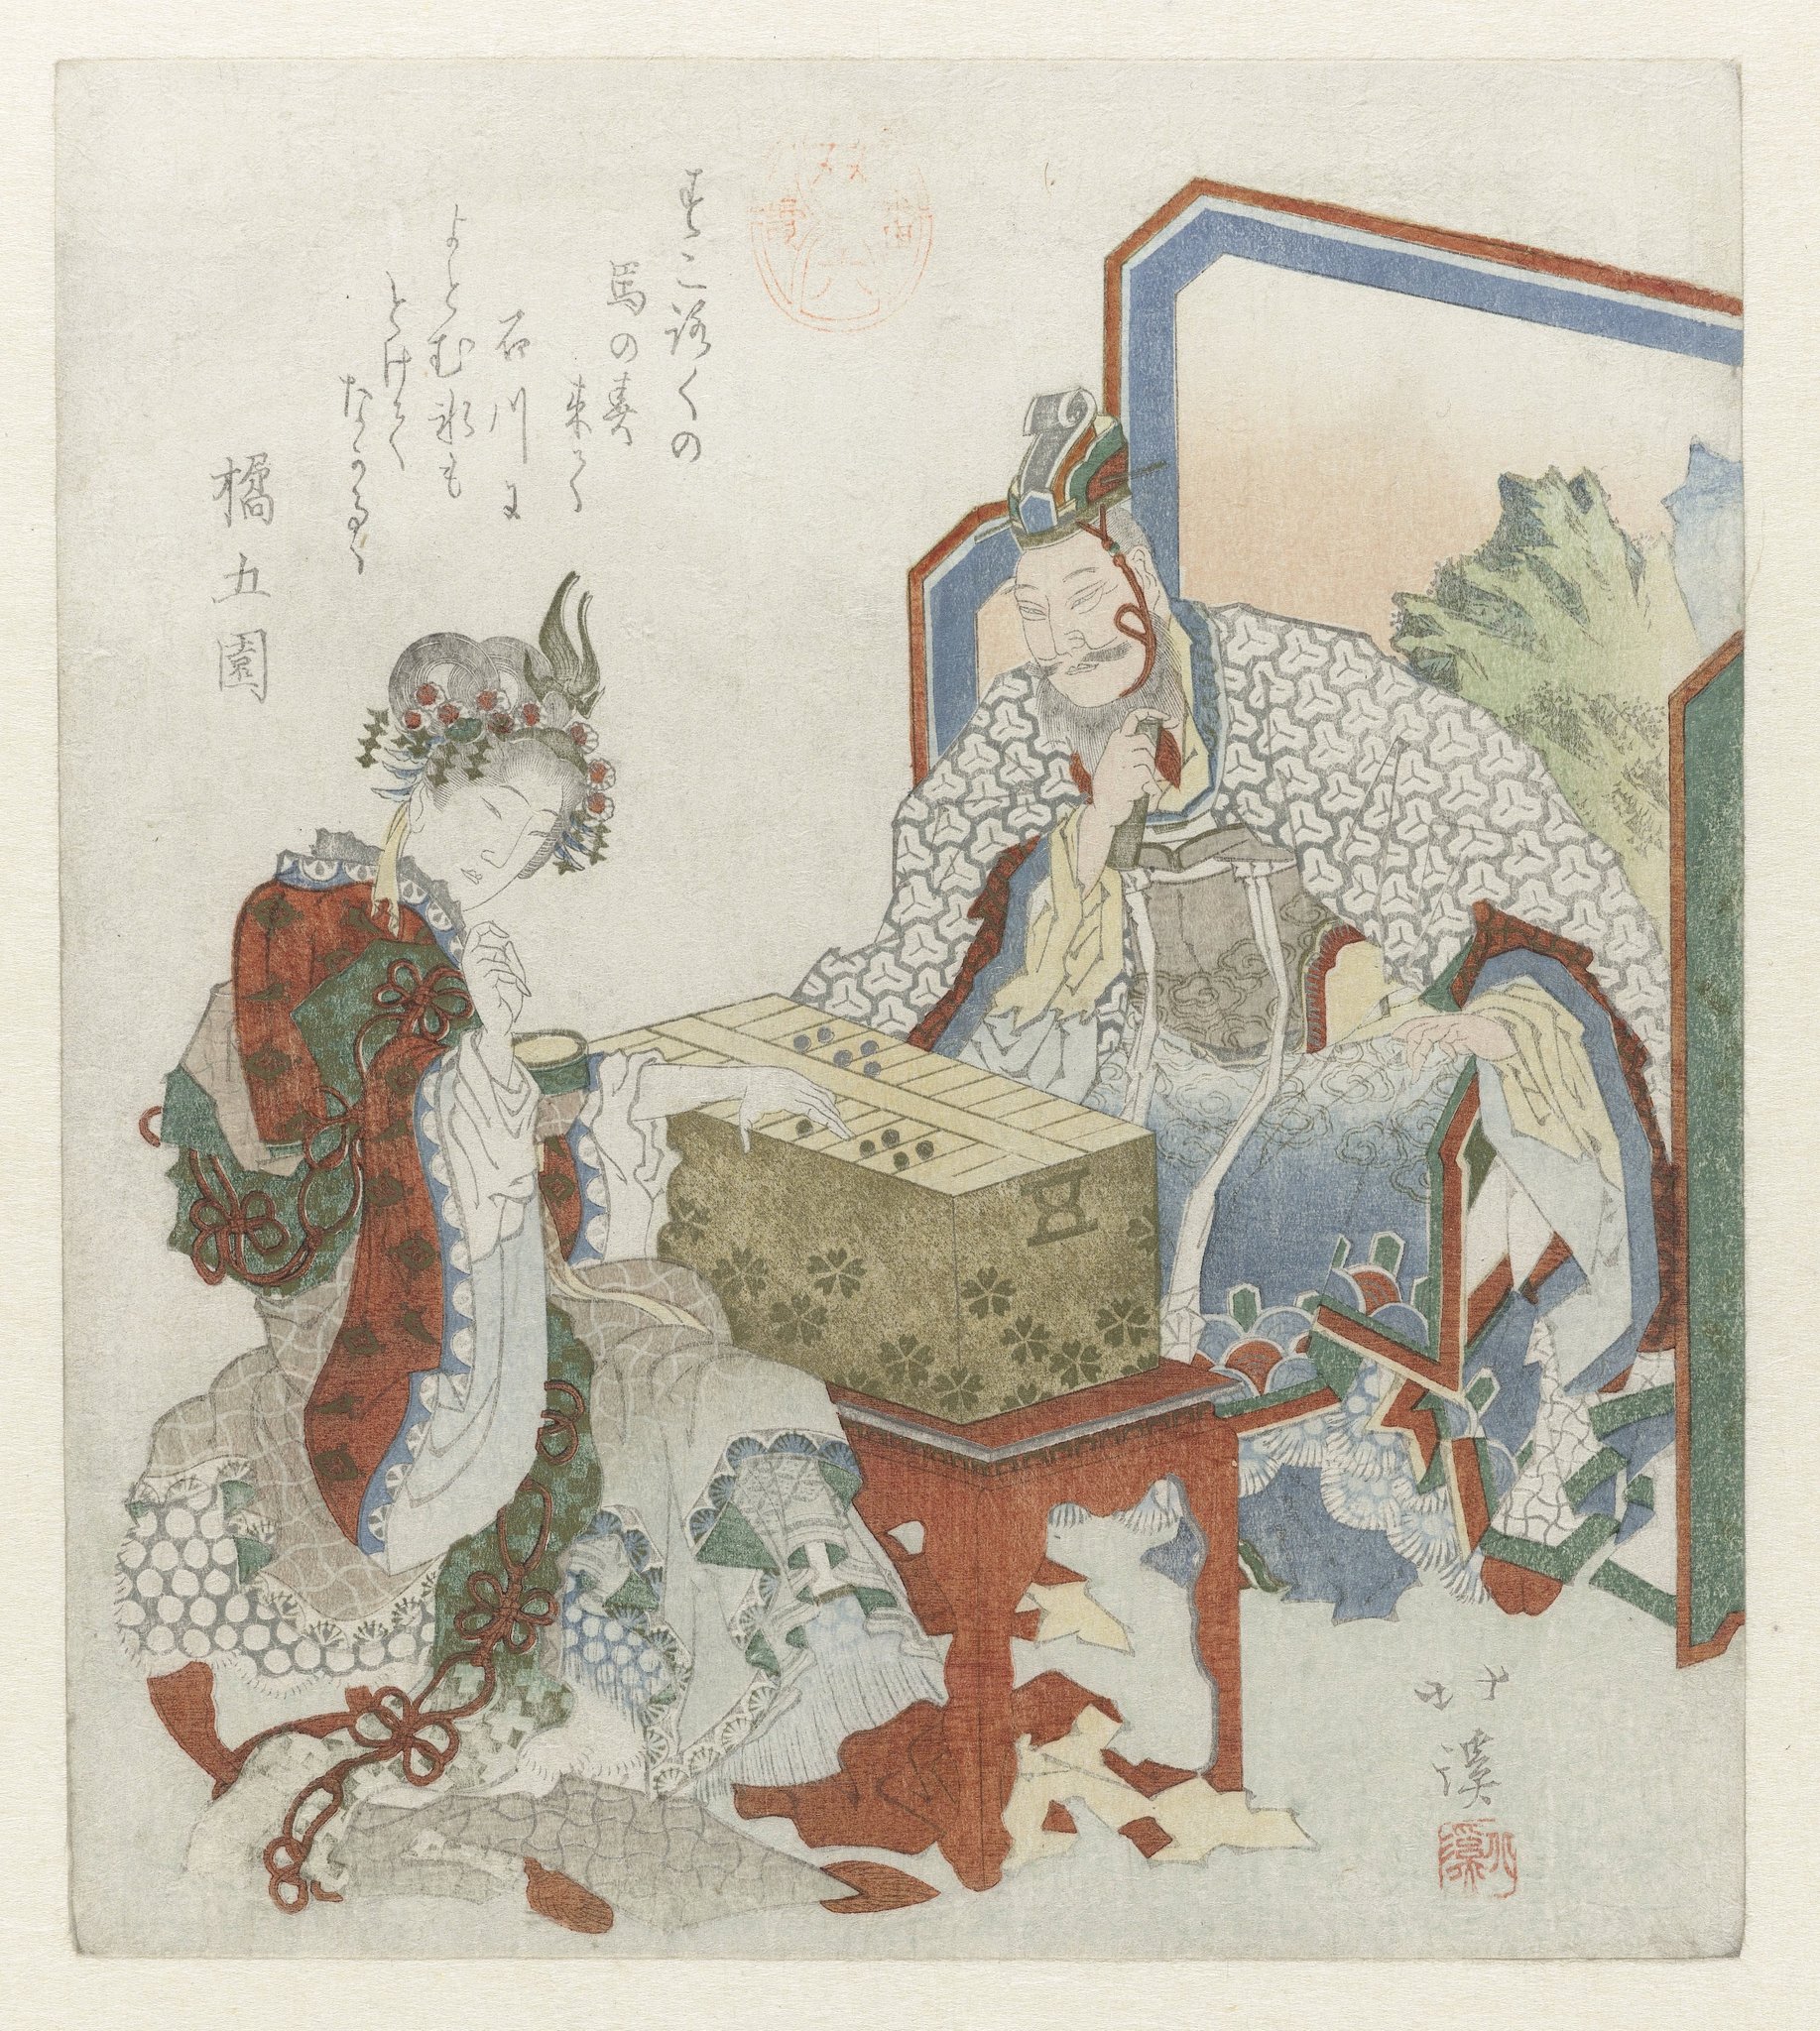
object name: surimono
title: A Man Playing Backgammon with a Lady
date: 1822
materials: paper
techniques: woodcut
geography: japan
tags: adult woman, adult man, backgammon, tric-trac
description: Een surimono is een luxe uitgevoerde prent waarop beeld met één of meerdere gedichten gecombineerd is. Bij het drukken van een surimono werd vaak gebruik gemaakt van dikker papier, blinddruk en metaal pigmenten, zoals koper- en zilverpoeder. De prenten werden vaak in opdracht van dichters gemaakt en als exclusief geschenk aan vrienden en relaties gegeven.